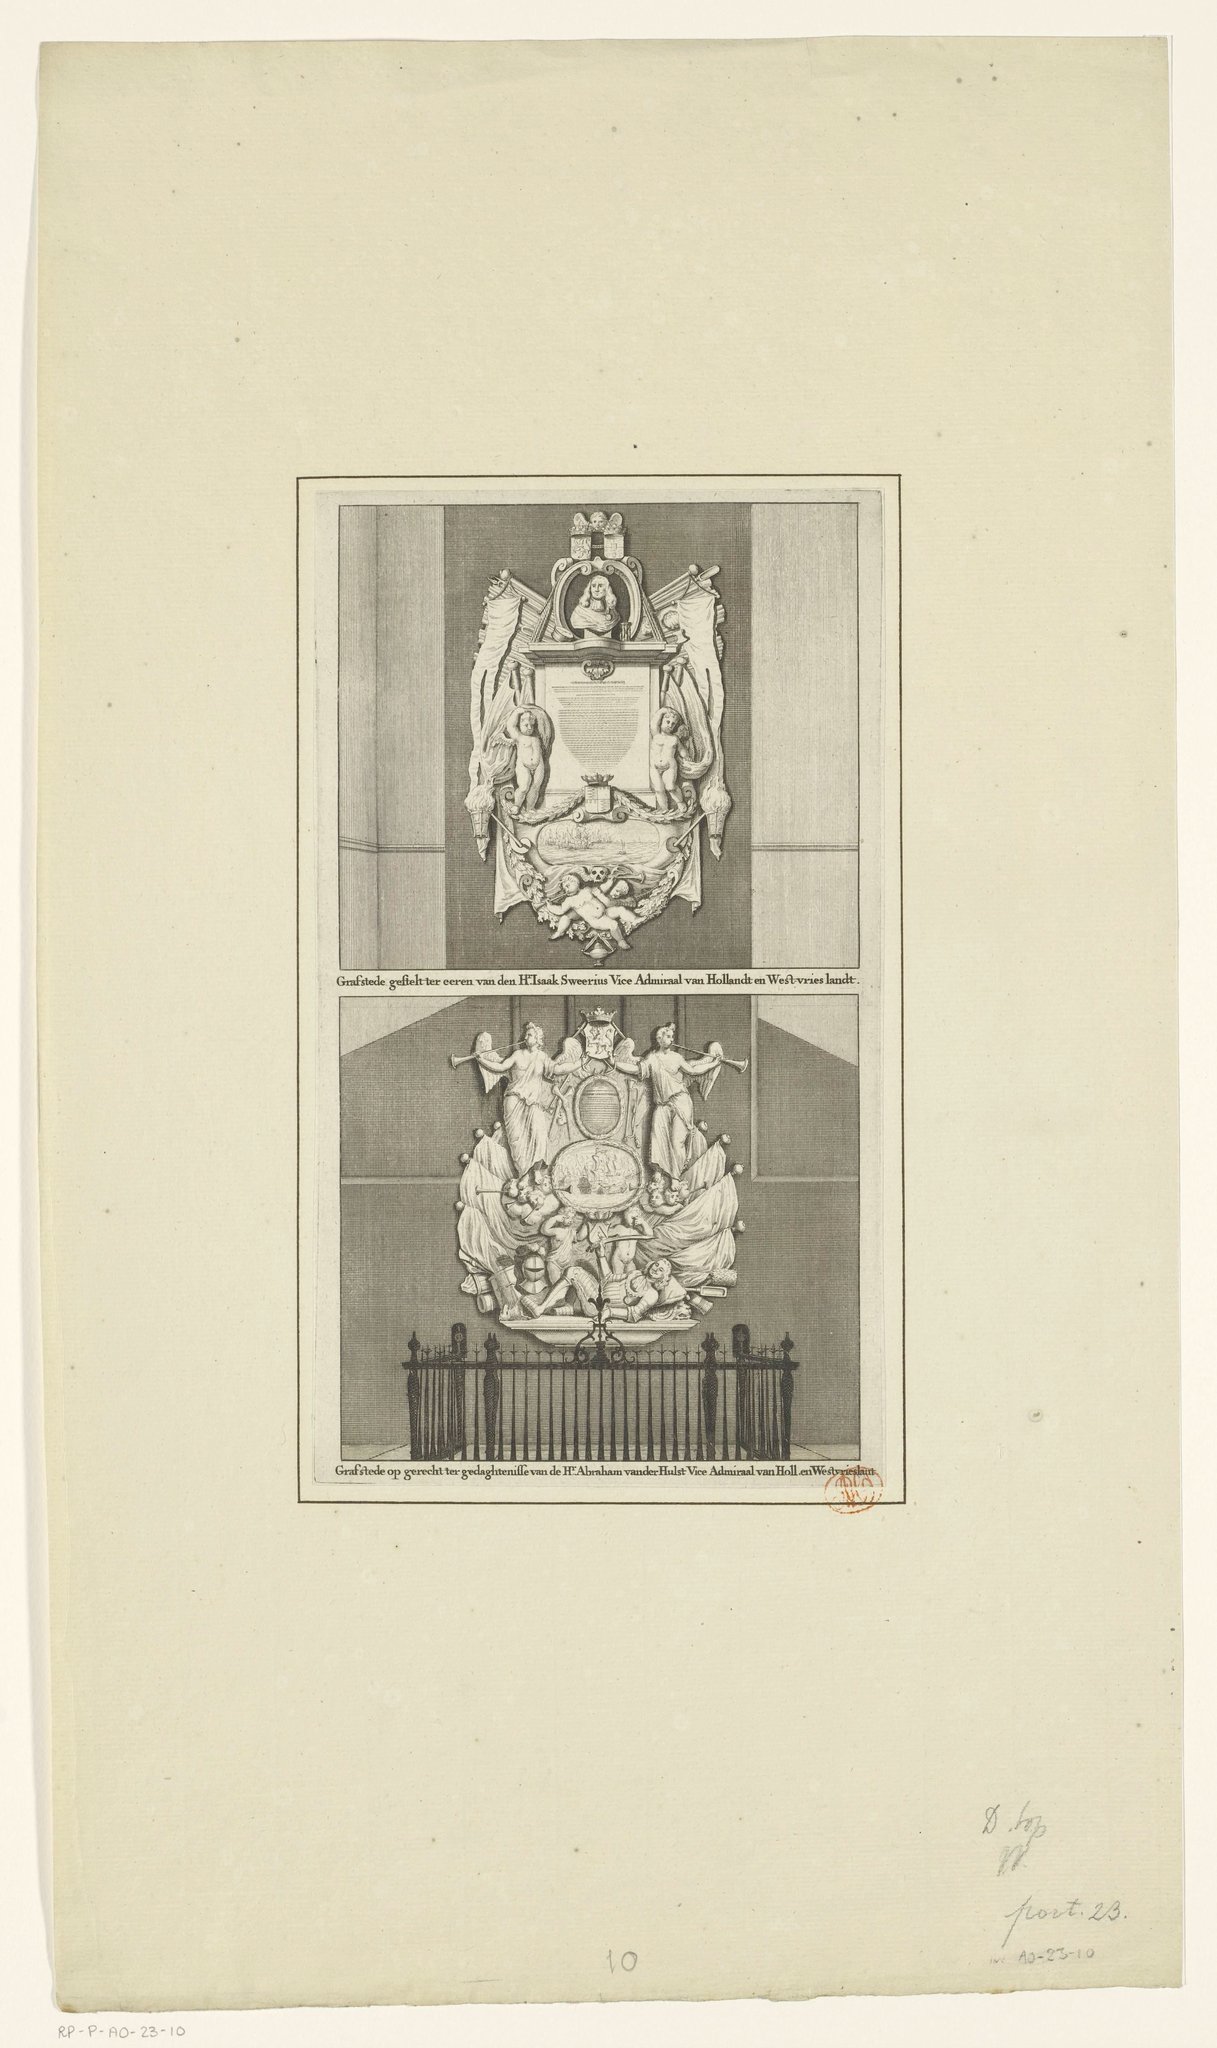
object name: print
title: Grafstede gestelt ter eeren van den Hr. Isaak Sweerius Vice Admiraal van Hollandt en West-vries landt / Grafstede op gerecht ter gedaghtenisse van de Hr. Abraham vander Hulst Vice Admiraal van Holl. en Westvrieslant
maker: Anonymous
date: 1693-1694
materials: paper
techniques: engraving, etching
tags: nijmegen, amsterdam, niche-tomb, wall-tomb, coat of arms (as symbol of the state, etc.) (+ nation; national), armorial bearing, heraldry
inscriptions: collector's mark: Lugt 195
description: Huidige staat van prent ook gebruikt in: Commelin, Caspar. Beschryvinge van Amsterdam, desselfs eerste oorspronk uyt den Huyse (…). 2 delen. Amsterdam: Abraham Wolfgang, Gillis Janssonius van Waesberge, Johannes Janssonius van Waesberge II, weduwe Dirk Boom I, Hendrick Boom en Rembertus Goethals, 1693. En in: Commelin, Caspar. Beschryvinge van Amsterdam, zynde een naukeurige verhandelinge van desselfs eerste oorspronk uyt (…). 2 delen. Amsterdam: weduwe Aart Dircksz Oossaan, 1694. Latere staat ook gebruikt in: Commelin, Caspar. Beschryvinge van Amsterdam, zynde een naukeurige verhandelinge van desselfs eerste oorspronk uyt (…). 2 delen. 2e druk. Amsterdam: Andries van Damme, Johannes Ratelband, weduwe A. van Aaltwyk en Hermanus Uytwerf, 1726. Deze prent is ook ingebonden in enkele exemplaren van: Wagenaar, Jan. Amsterdam, in zyne opkomst, aanwas, geschiedenissen (…). 3 delen [folio-uitgave]. Amsterdam: Isaak Tirion en Yntema & Tieboel, 1760-1767, dl. 2 (Isaak Tirion, 1765). Komt echter niet voor in de lijst met in te binden prenten van deze uitgave (te vinden in dl. 3) - en is er dus ook niet voor bedoeld.